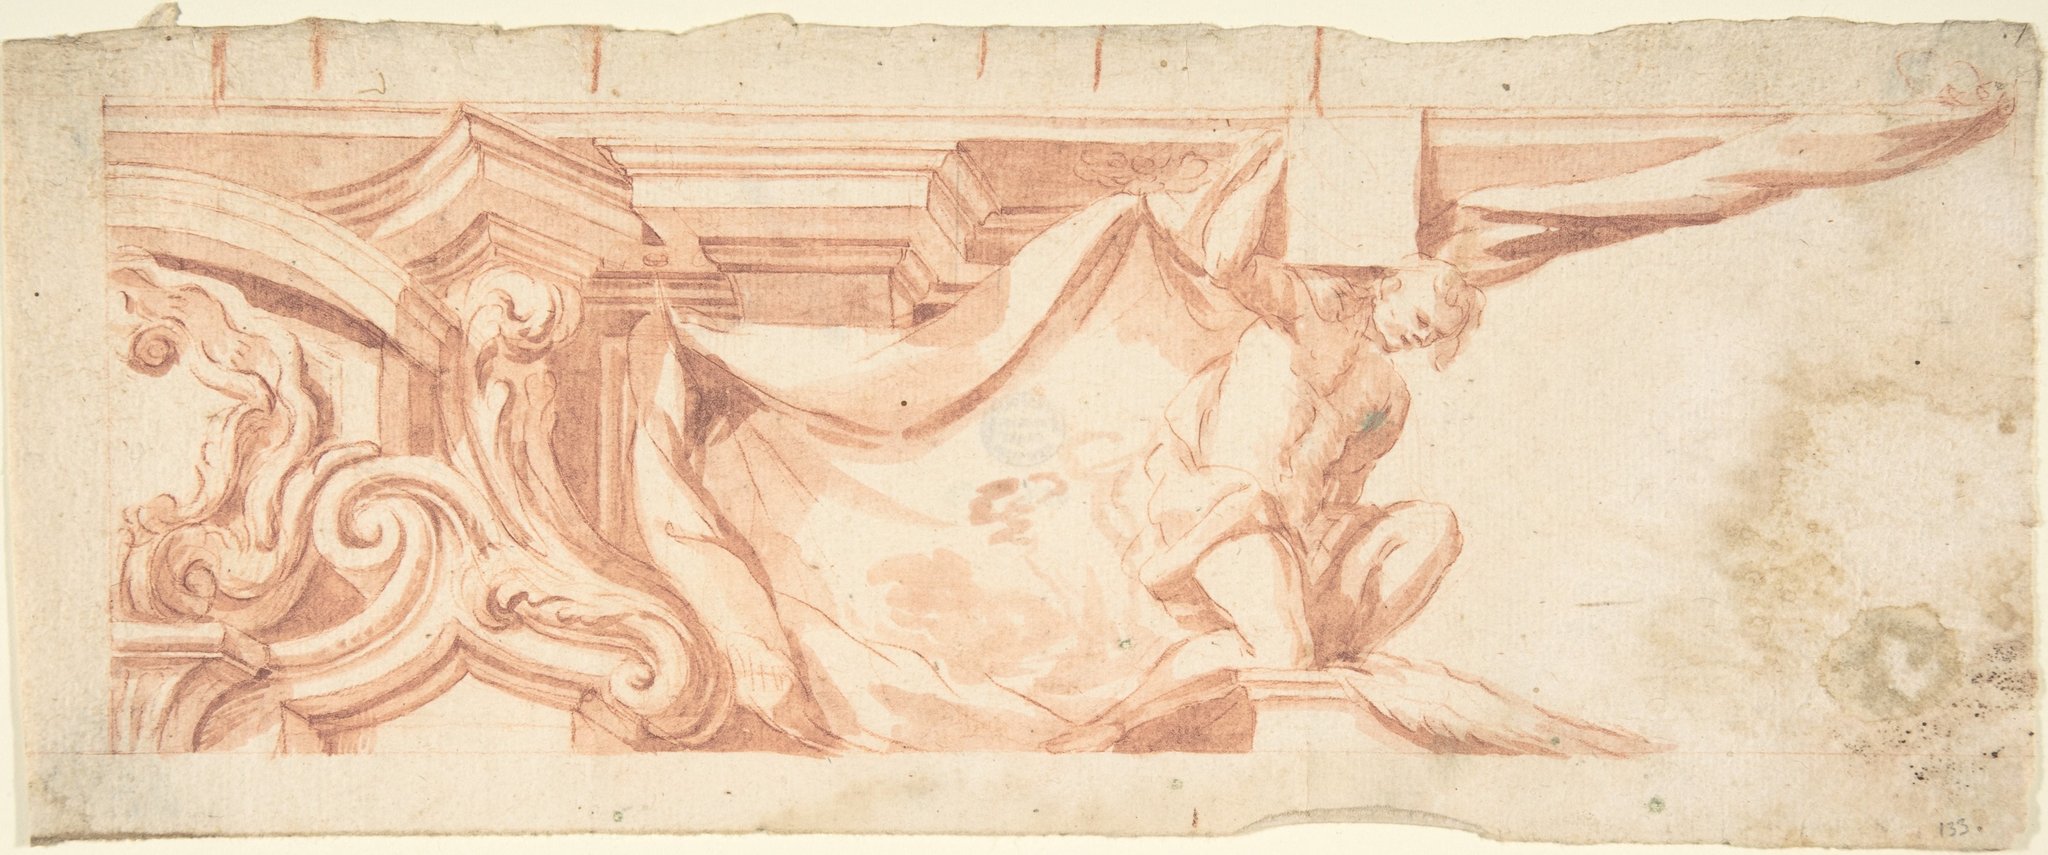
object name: drawing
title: Ornamental Design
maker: anonymous, italian, piedmontese, 18th century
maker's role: artist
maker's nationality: italian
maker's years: 1700-1800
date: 1700-1780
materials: chalk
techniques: brush, wash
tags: ornament,men